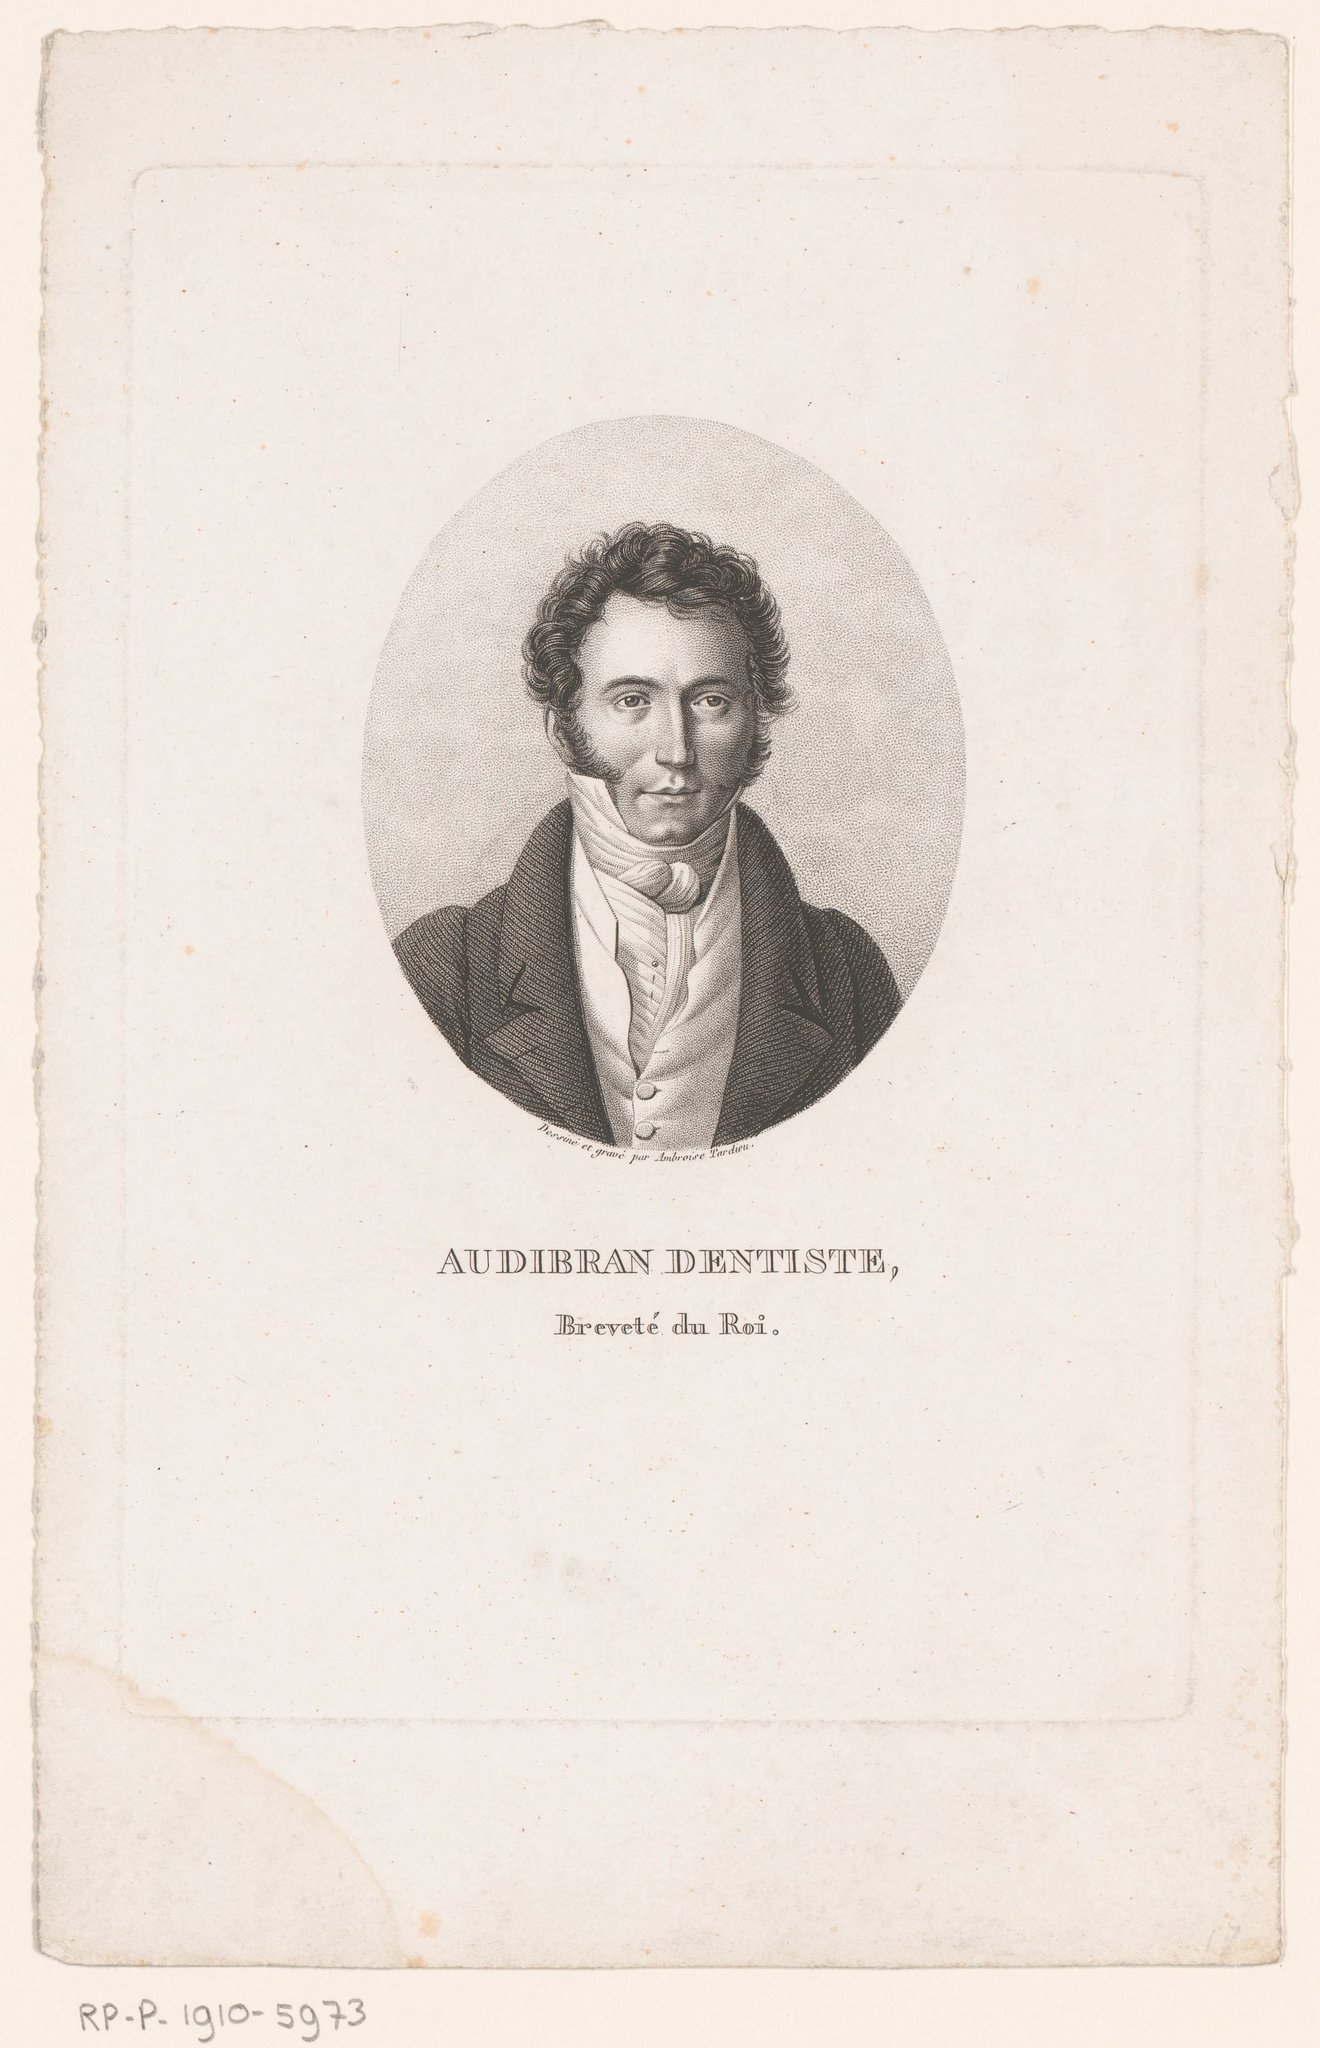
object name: print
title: Portret van Joseph Audibran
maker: ambroise tardieu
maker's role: print maker, printer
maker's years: 1788-1841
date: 1798-1841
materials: paper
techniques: engraving, etching, roulette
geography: paris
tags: historical persons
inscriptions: collector's mark: Lugt 2228